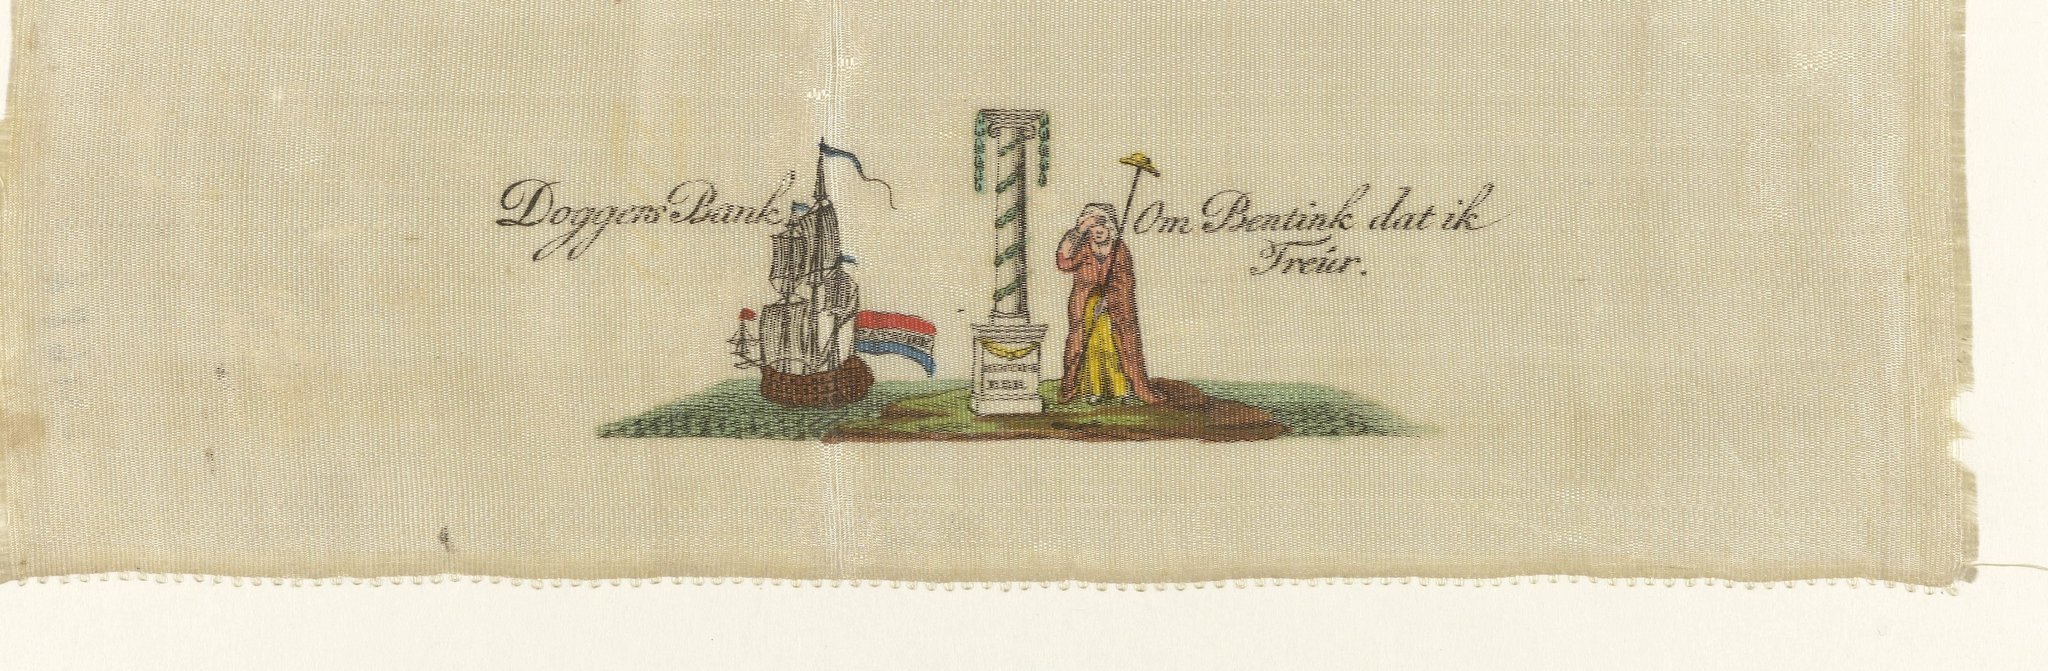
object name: hatband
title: Doggersbanklint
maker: Anonymous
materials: silk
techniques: etching, hand coloring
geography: netherlands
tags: amsterdam, personifications of countries, nations, states, districts, etc., battle (+ naval force), grave, tomb and other grave-forms and grave-markers, netherlands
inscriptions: inscription: ‘Doggers-Bank / Om Bentink dat ik Treur’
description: Een Nederlands fregat met een vlag waarop staat 'Batavier' en een erezuil voor Baron Bentinck waarnaast de treurende Nederlandse Maagd staat. Verwijzing naar de overwinning in de zeeslag bij Doggersbank op 5 augustus 1781 tussen de Nederlandse en de Engelse vloot en het overlijden van Wolter Jan Gerrit baron Bentinck op 23/24 augustus 1781. Voorstelling op een zijden lint dat als versiering aan de hoed werd gedragen.